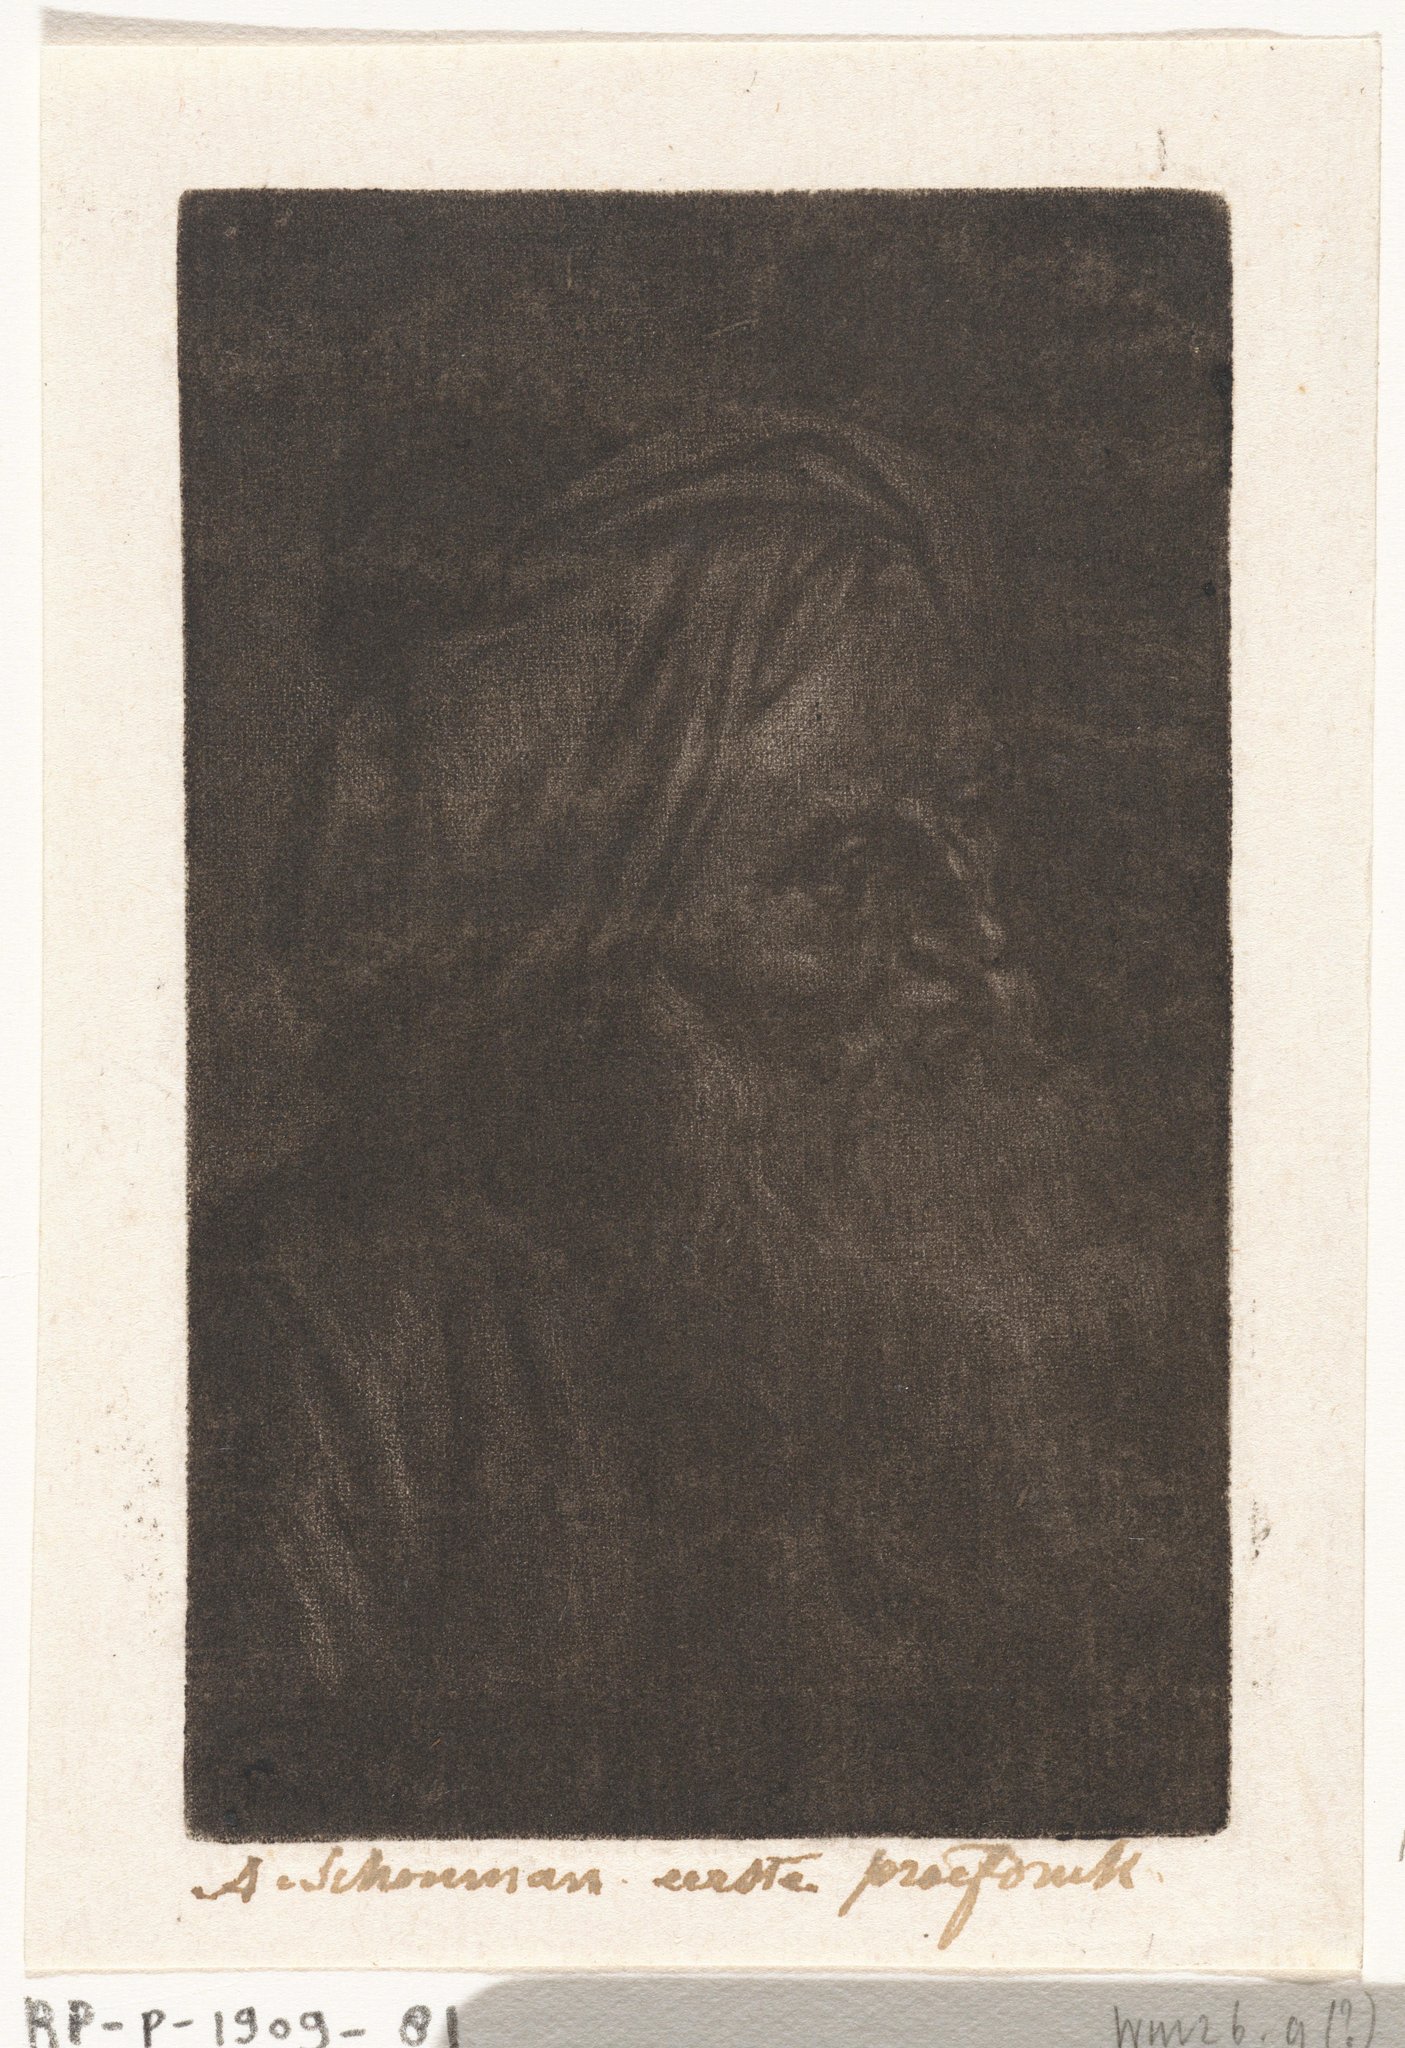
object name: print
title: Buste van een man met tulband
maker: aert schouman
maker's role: draughtsman, painter, print maker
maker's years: 1710-1792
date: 1746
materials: paper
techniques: mezzotint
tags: head-gear: turban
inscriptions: collector's mark: Lugt 2228